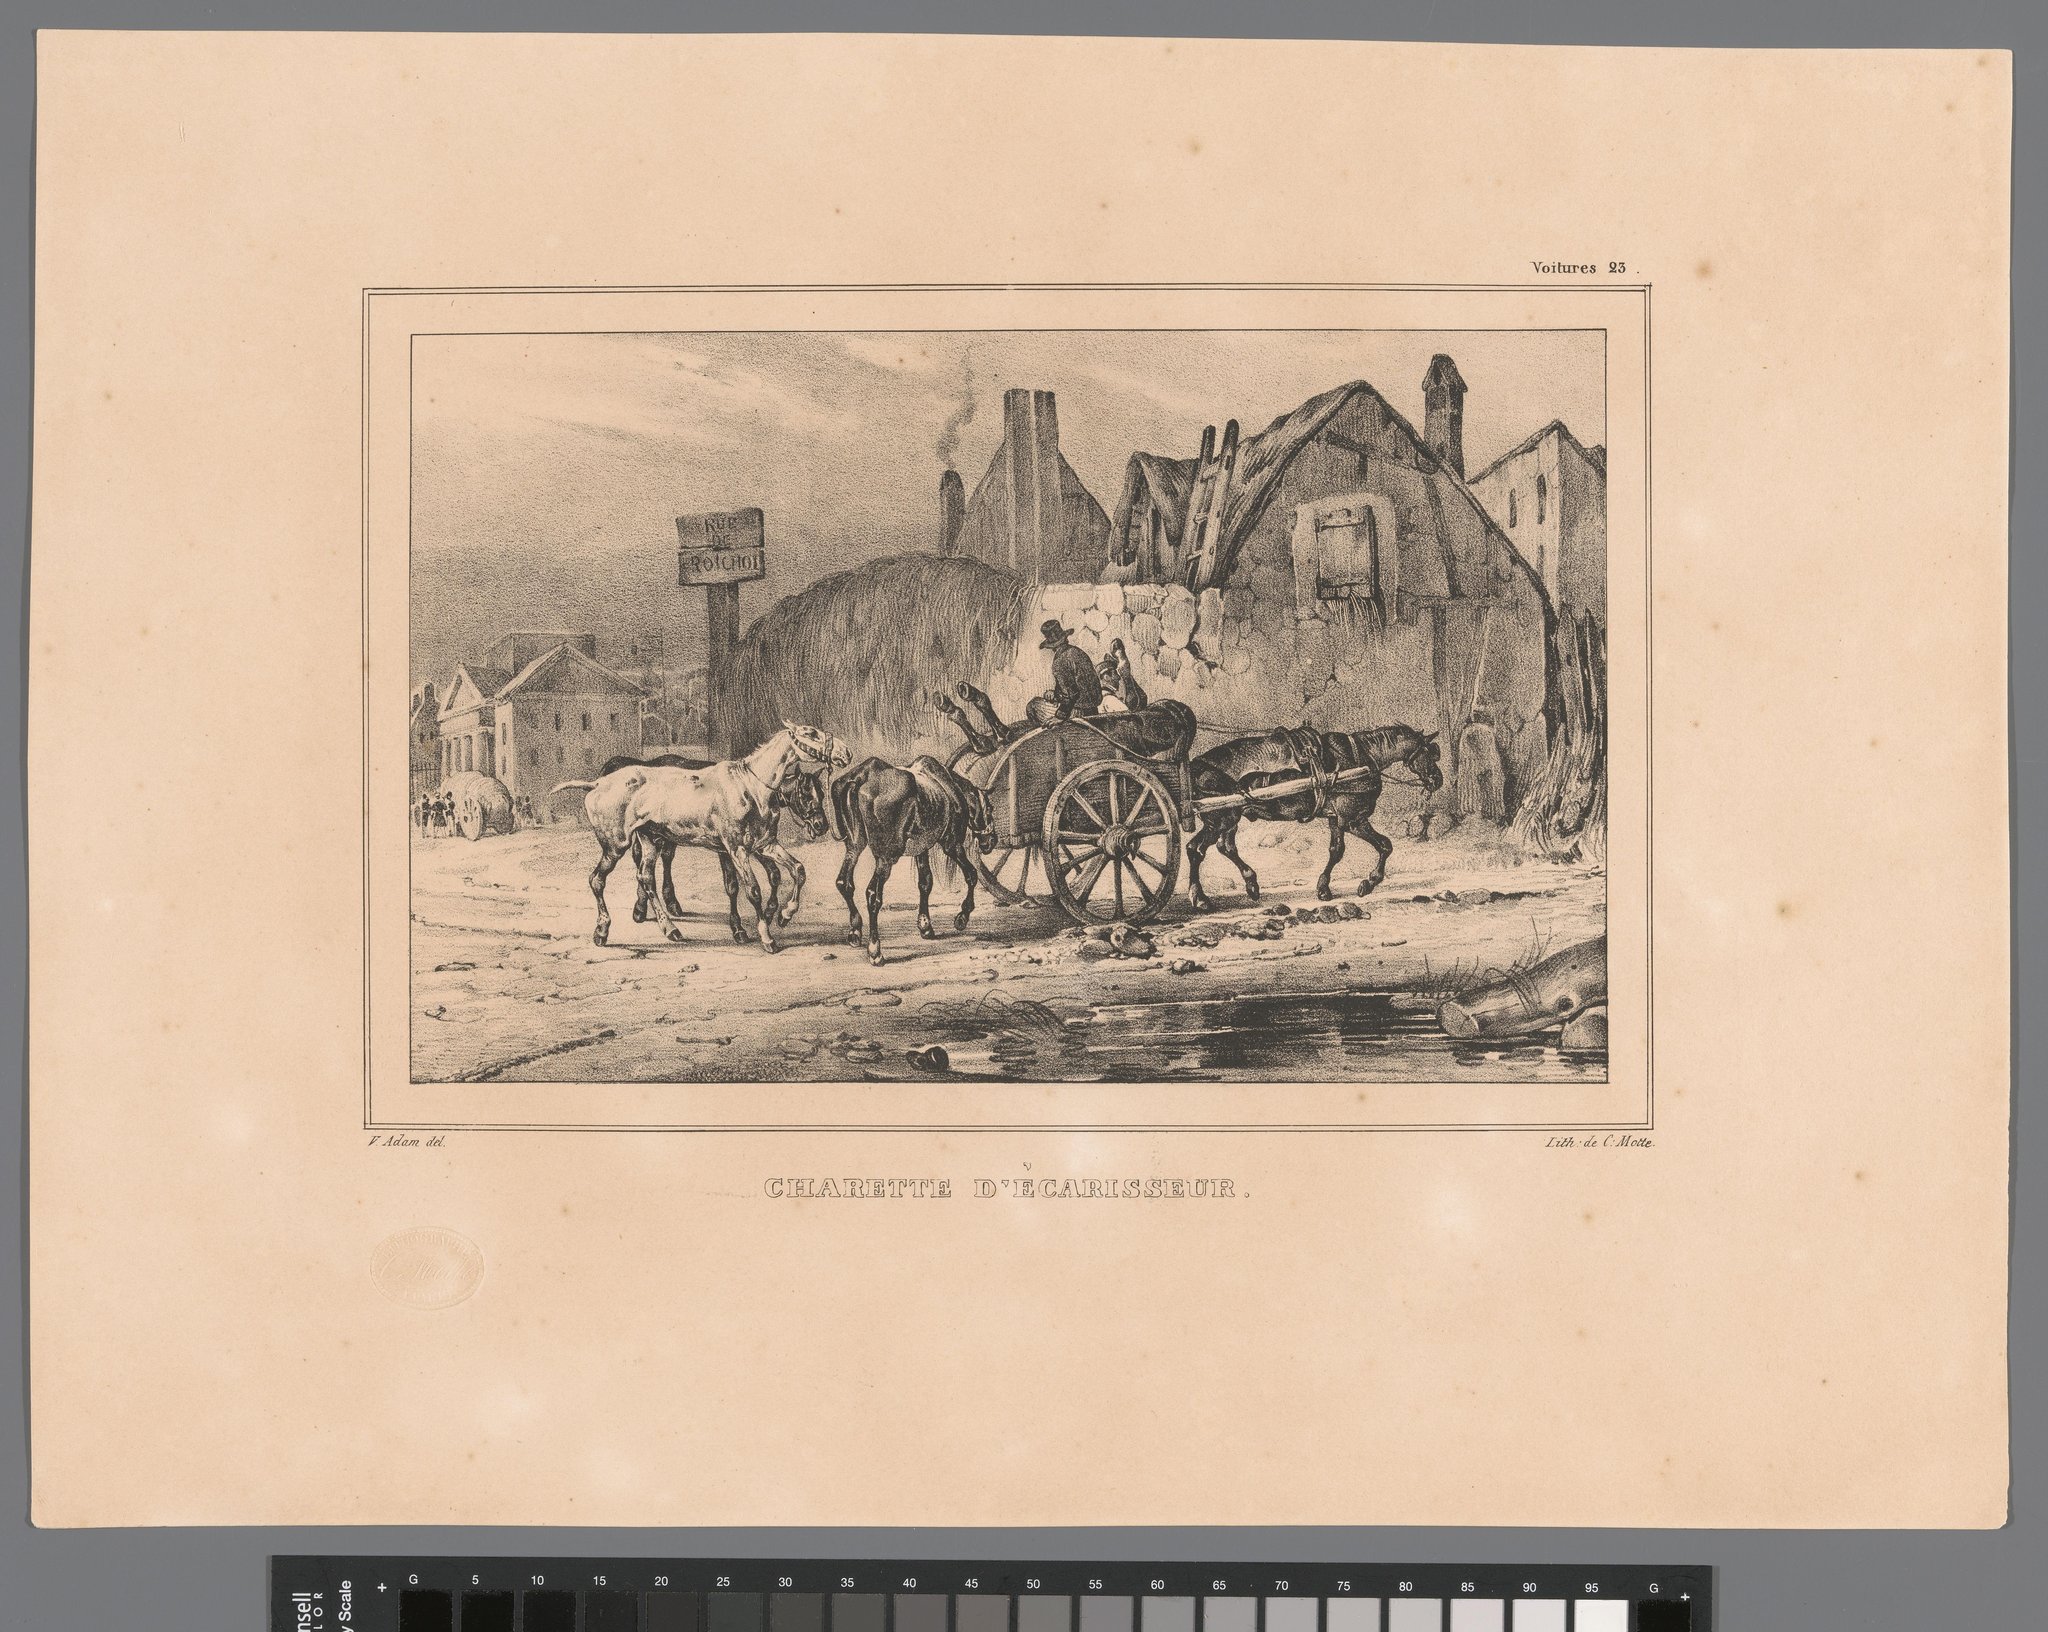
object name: print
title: Charette d'écarisseur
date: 1828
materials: paper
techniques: lithograph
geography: paris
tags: butcher, slaughterman, two-wheeled vehicle drawn by one animal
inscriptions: collector's mark: Lugt 2228, stamp: Lugt 1828c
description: De prentserie waar deze prent deel van uitmaakt werd in drie delen van twaalf prenten vanaf 1827 tot en met 1830 gepubliceerd. Elk van de drie delen werd voorzien van een aparte omslag.